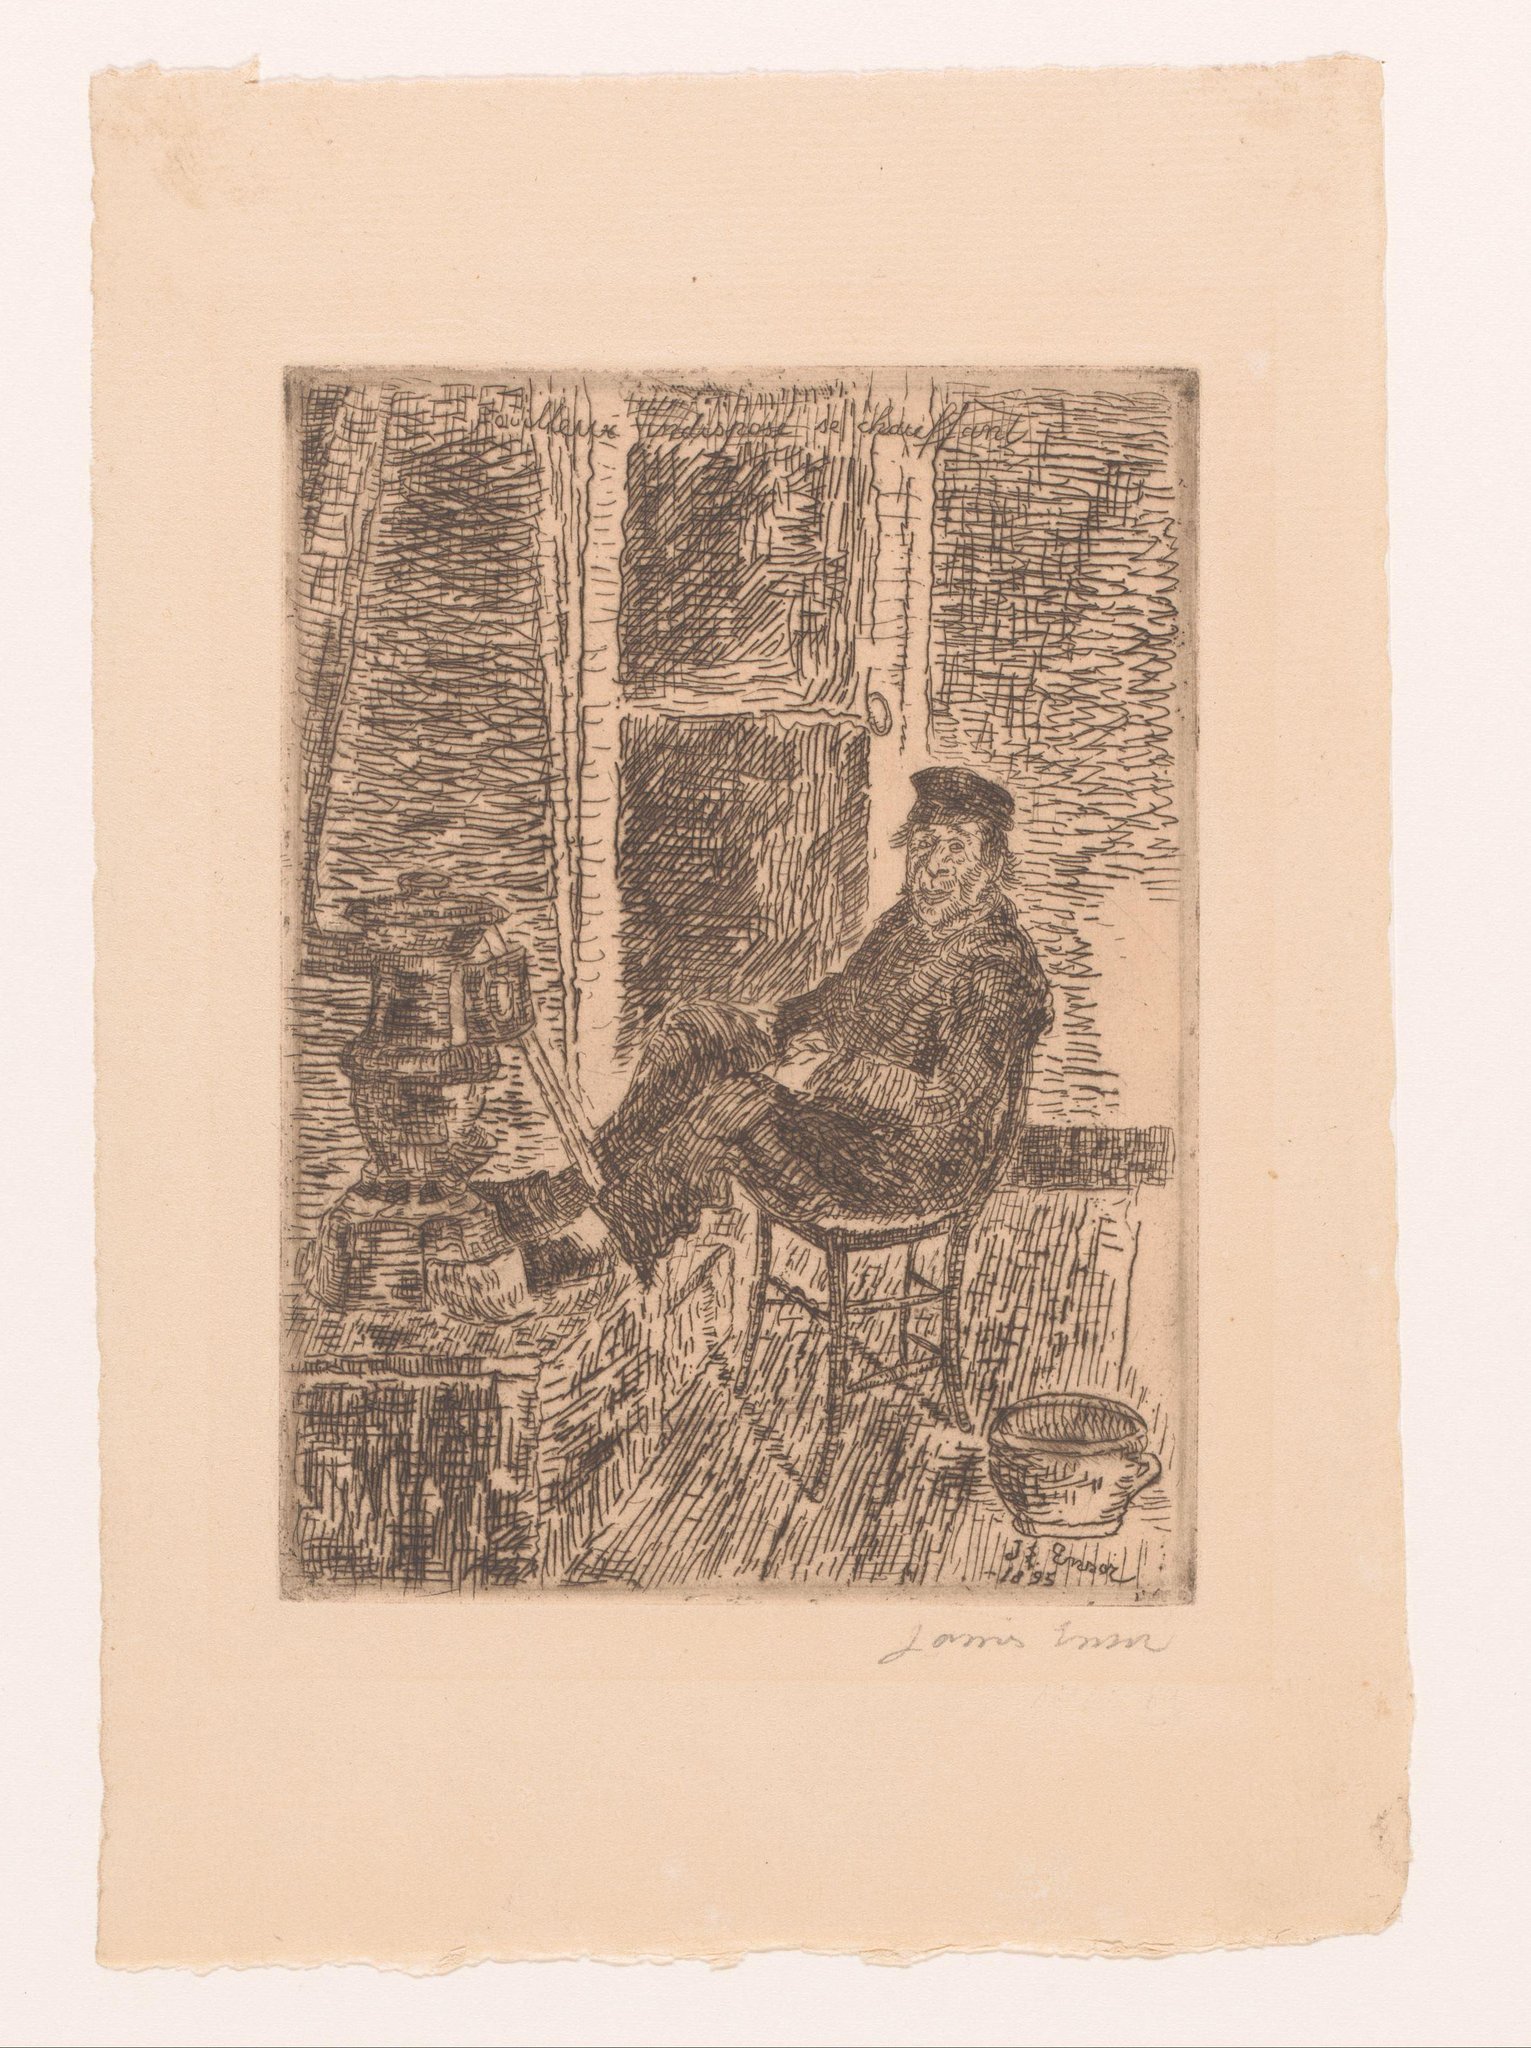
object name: print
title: Man gezeten voor een kachel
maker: james ensor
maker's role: print maker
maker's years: 1860-1949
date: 1895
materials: paper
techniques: etching, intaglio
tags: adult man, heating stove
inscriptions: collector's mark: Lugt 2228